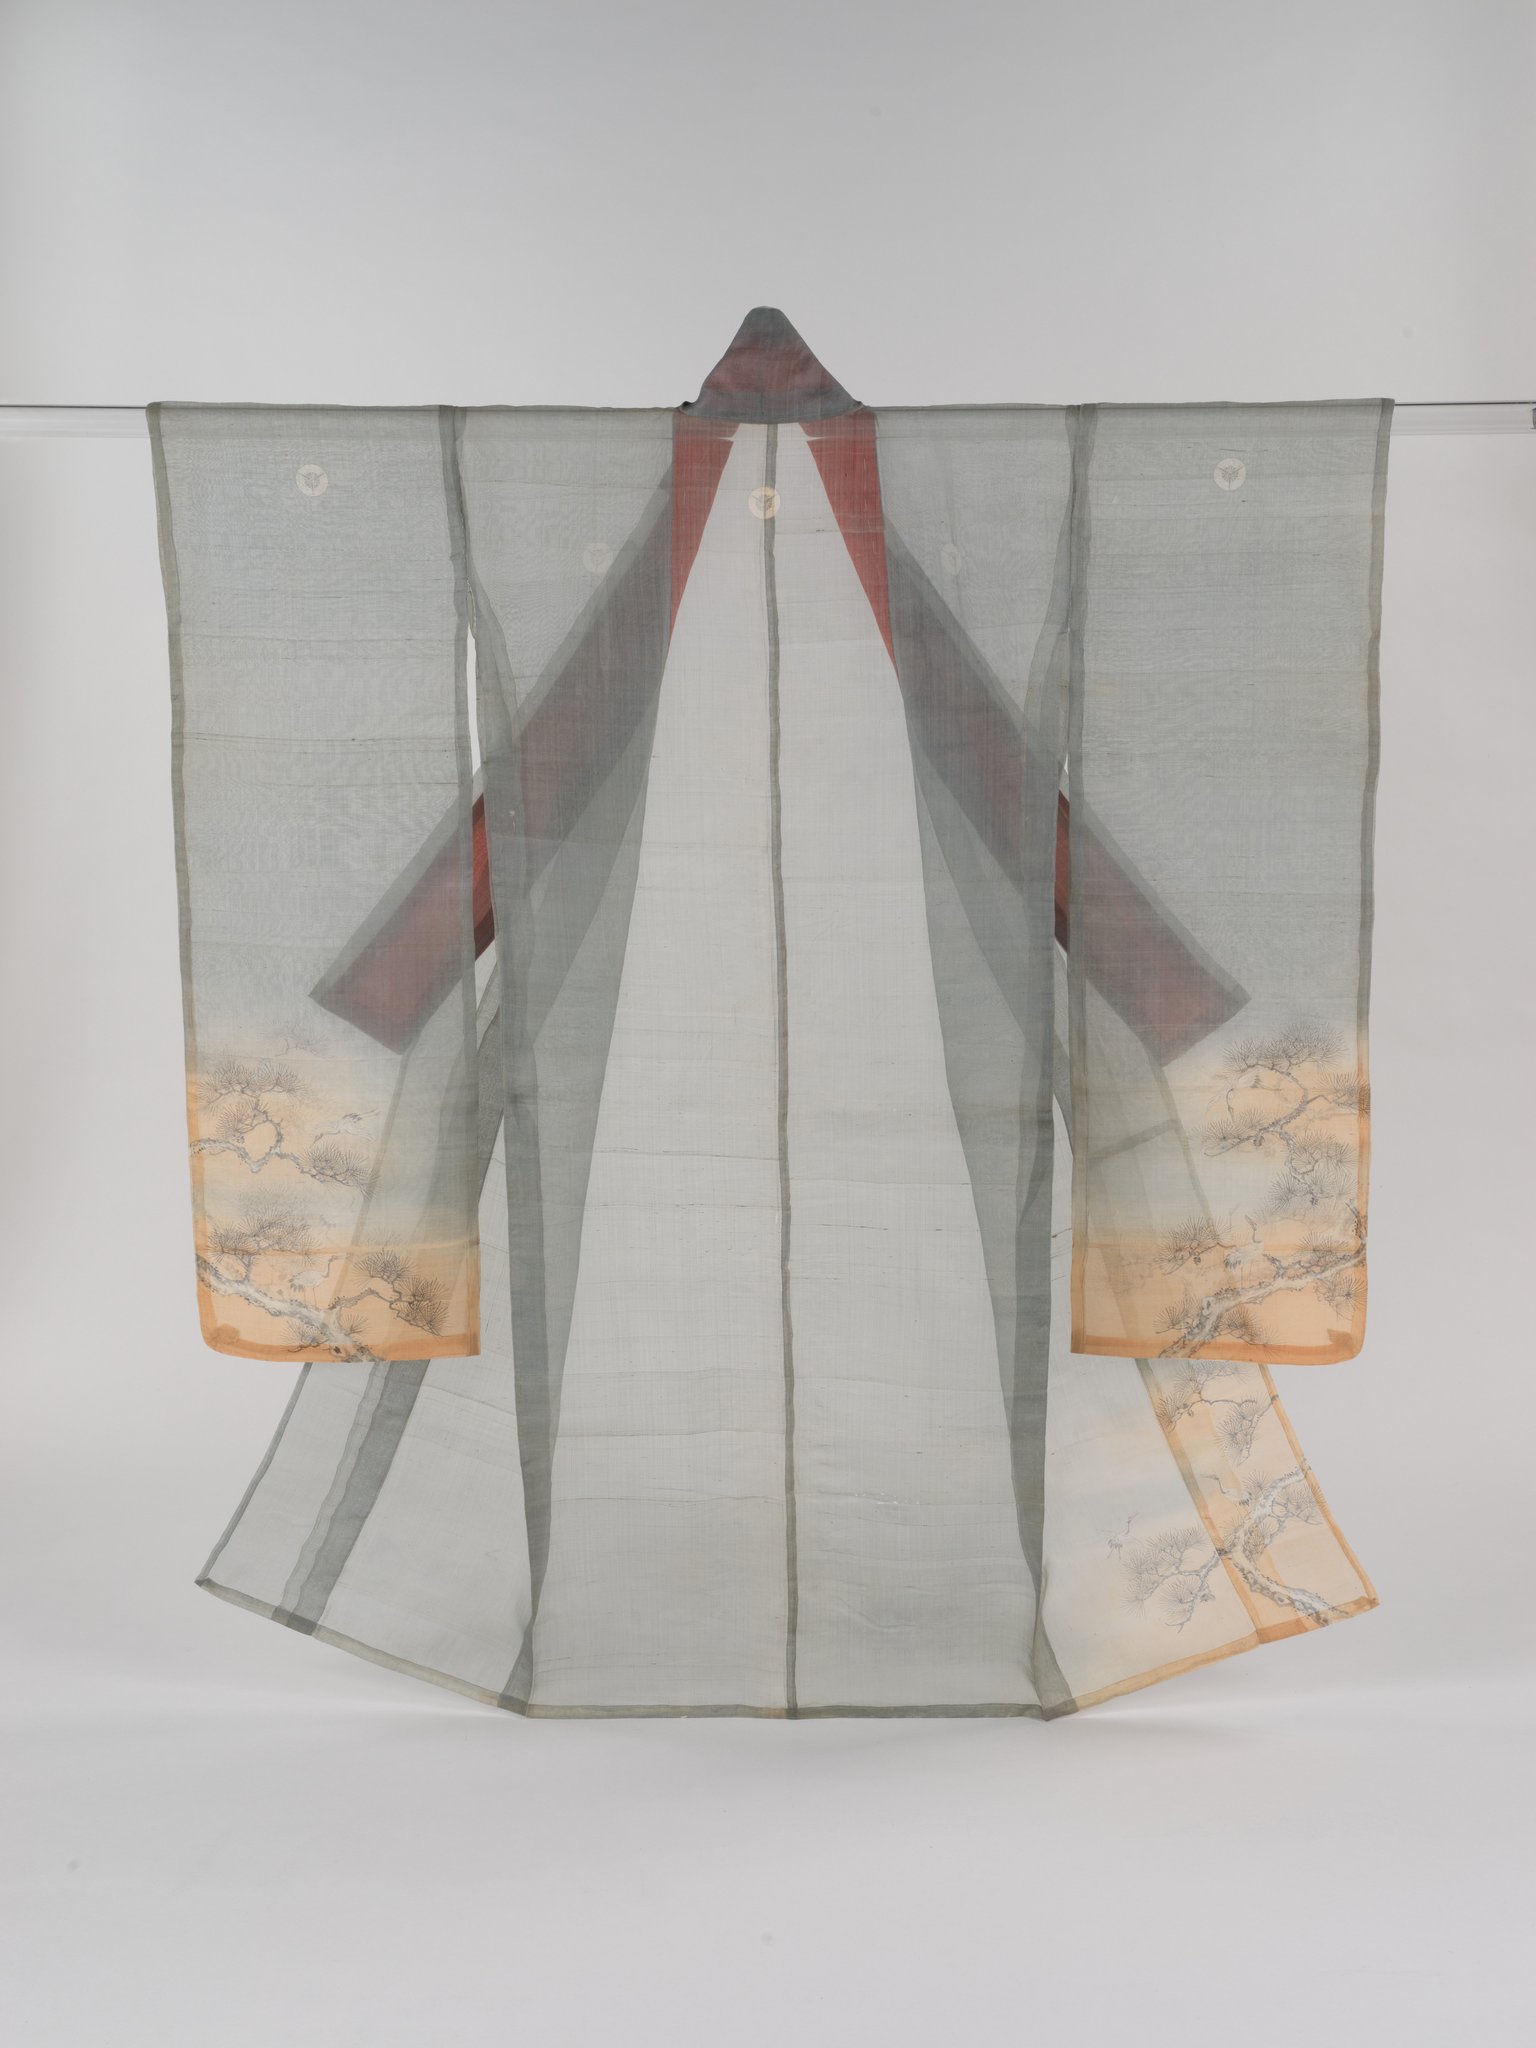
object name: kimono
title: Summer robe (hito-e) with cranes and pines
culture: japanese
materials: paste, silk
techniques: weave, resist